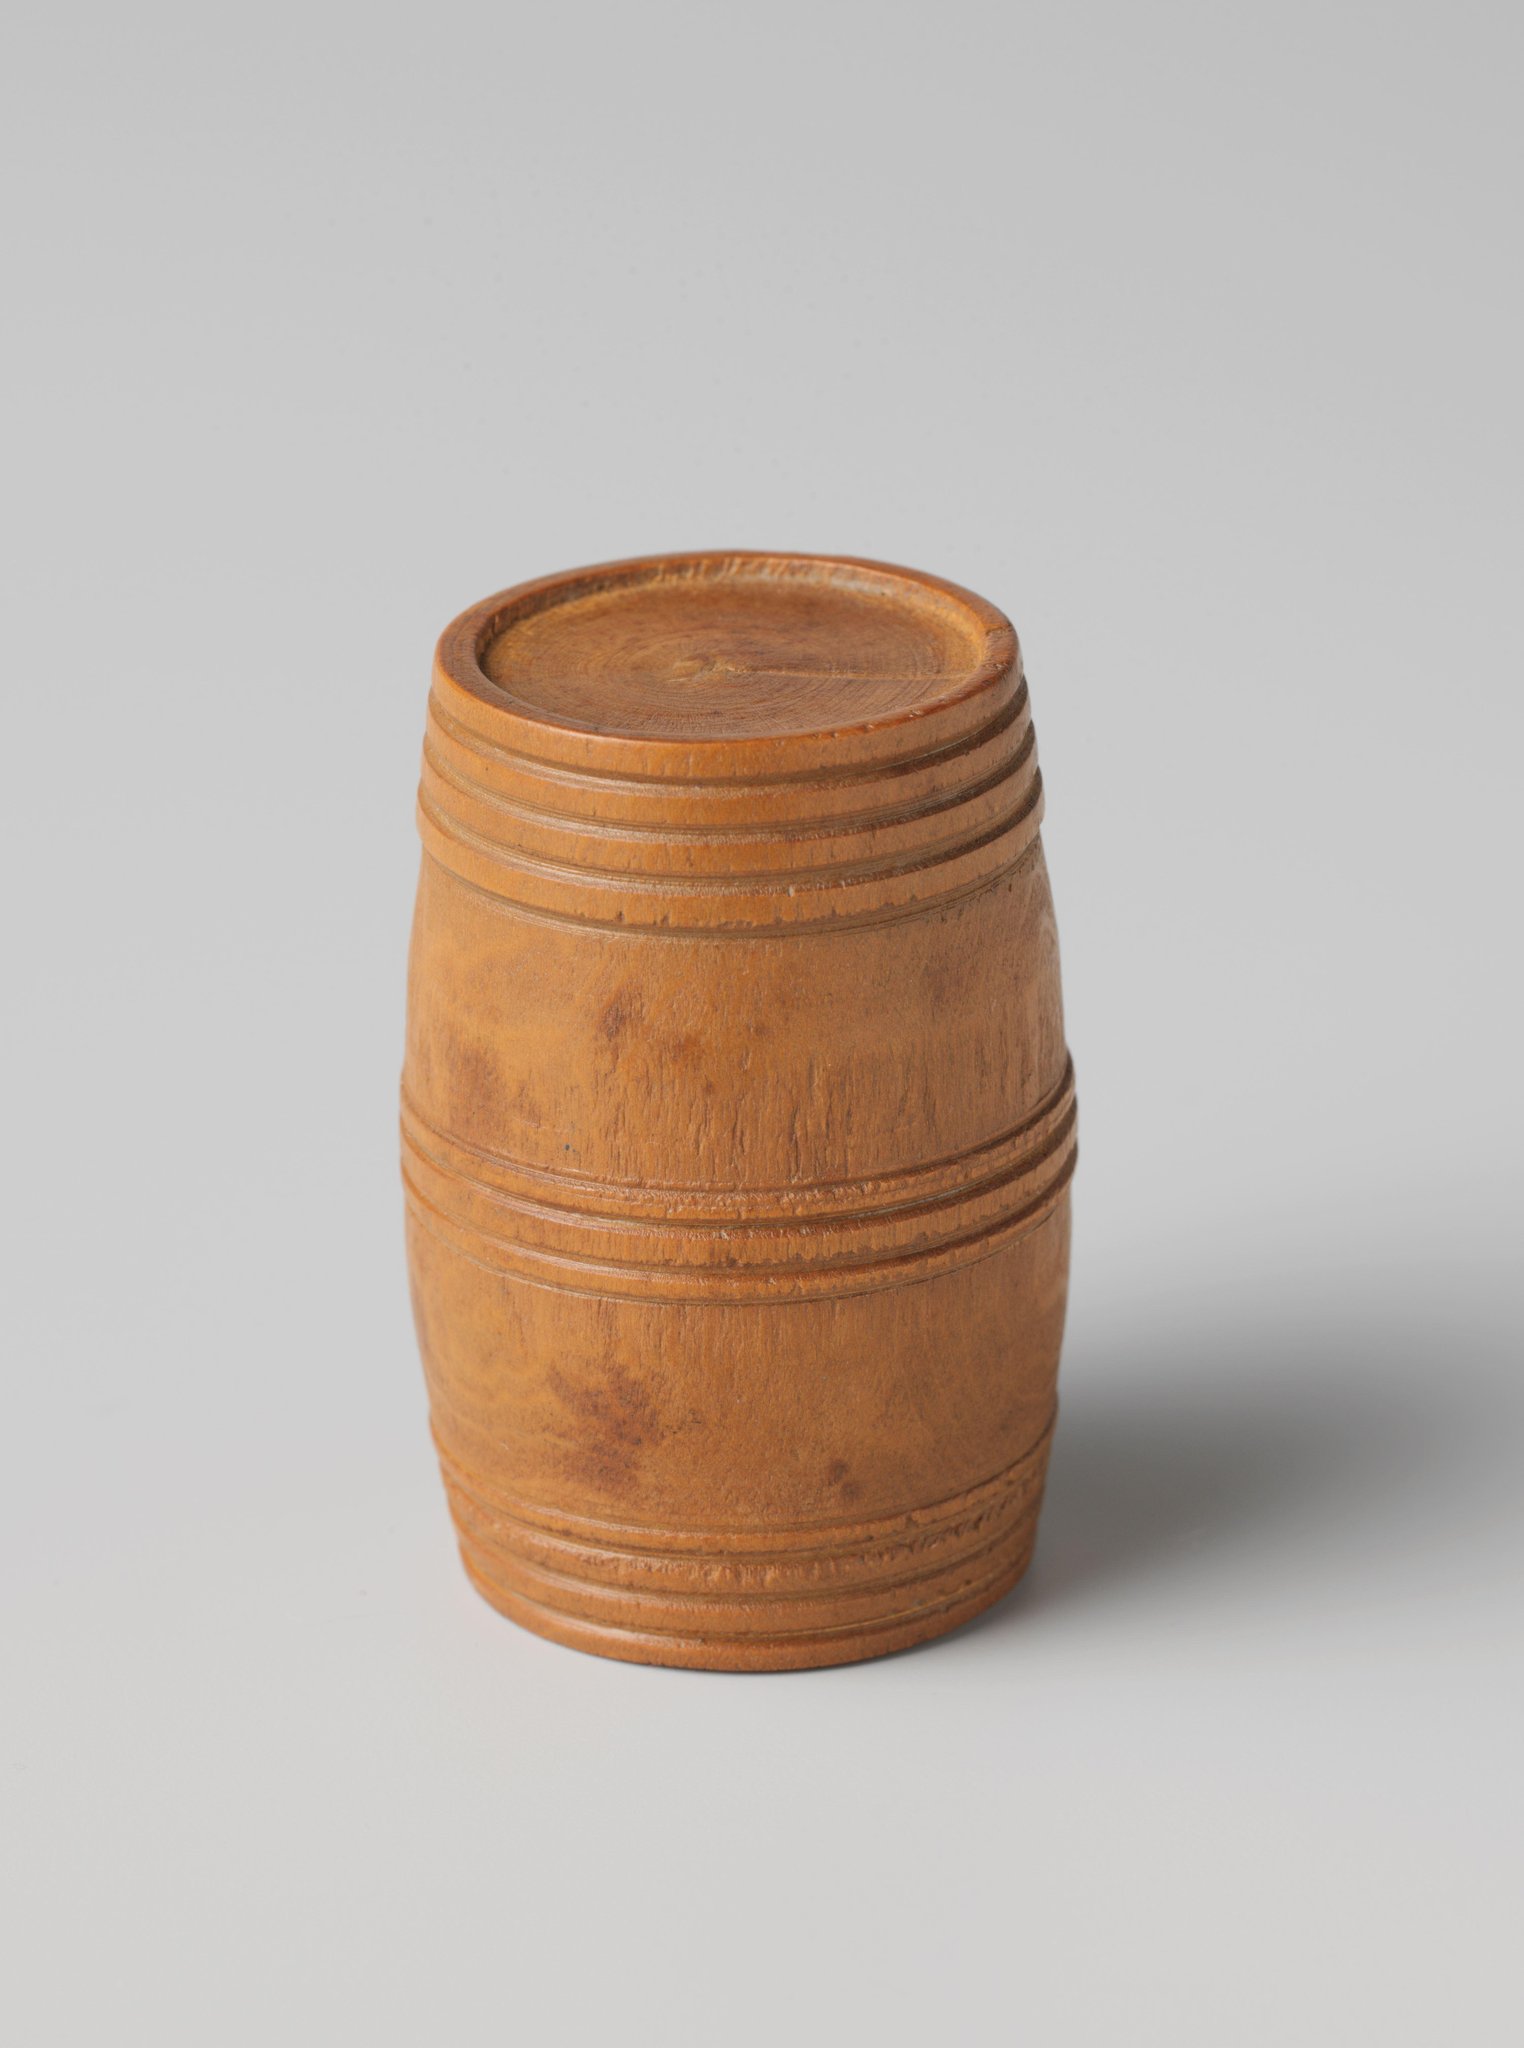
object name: miniature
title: Vat van gedraaid, massief hout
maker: Anonymous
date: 1700-1800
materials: wood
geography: amsterdam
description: Een vat gedraaid van massief esdoornhout.